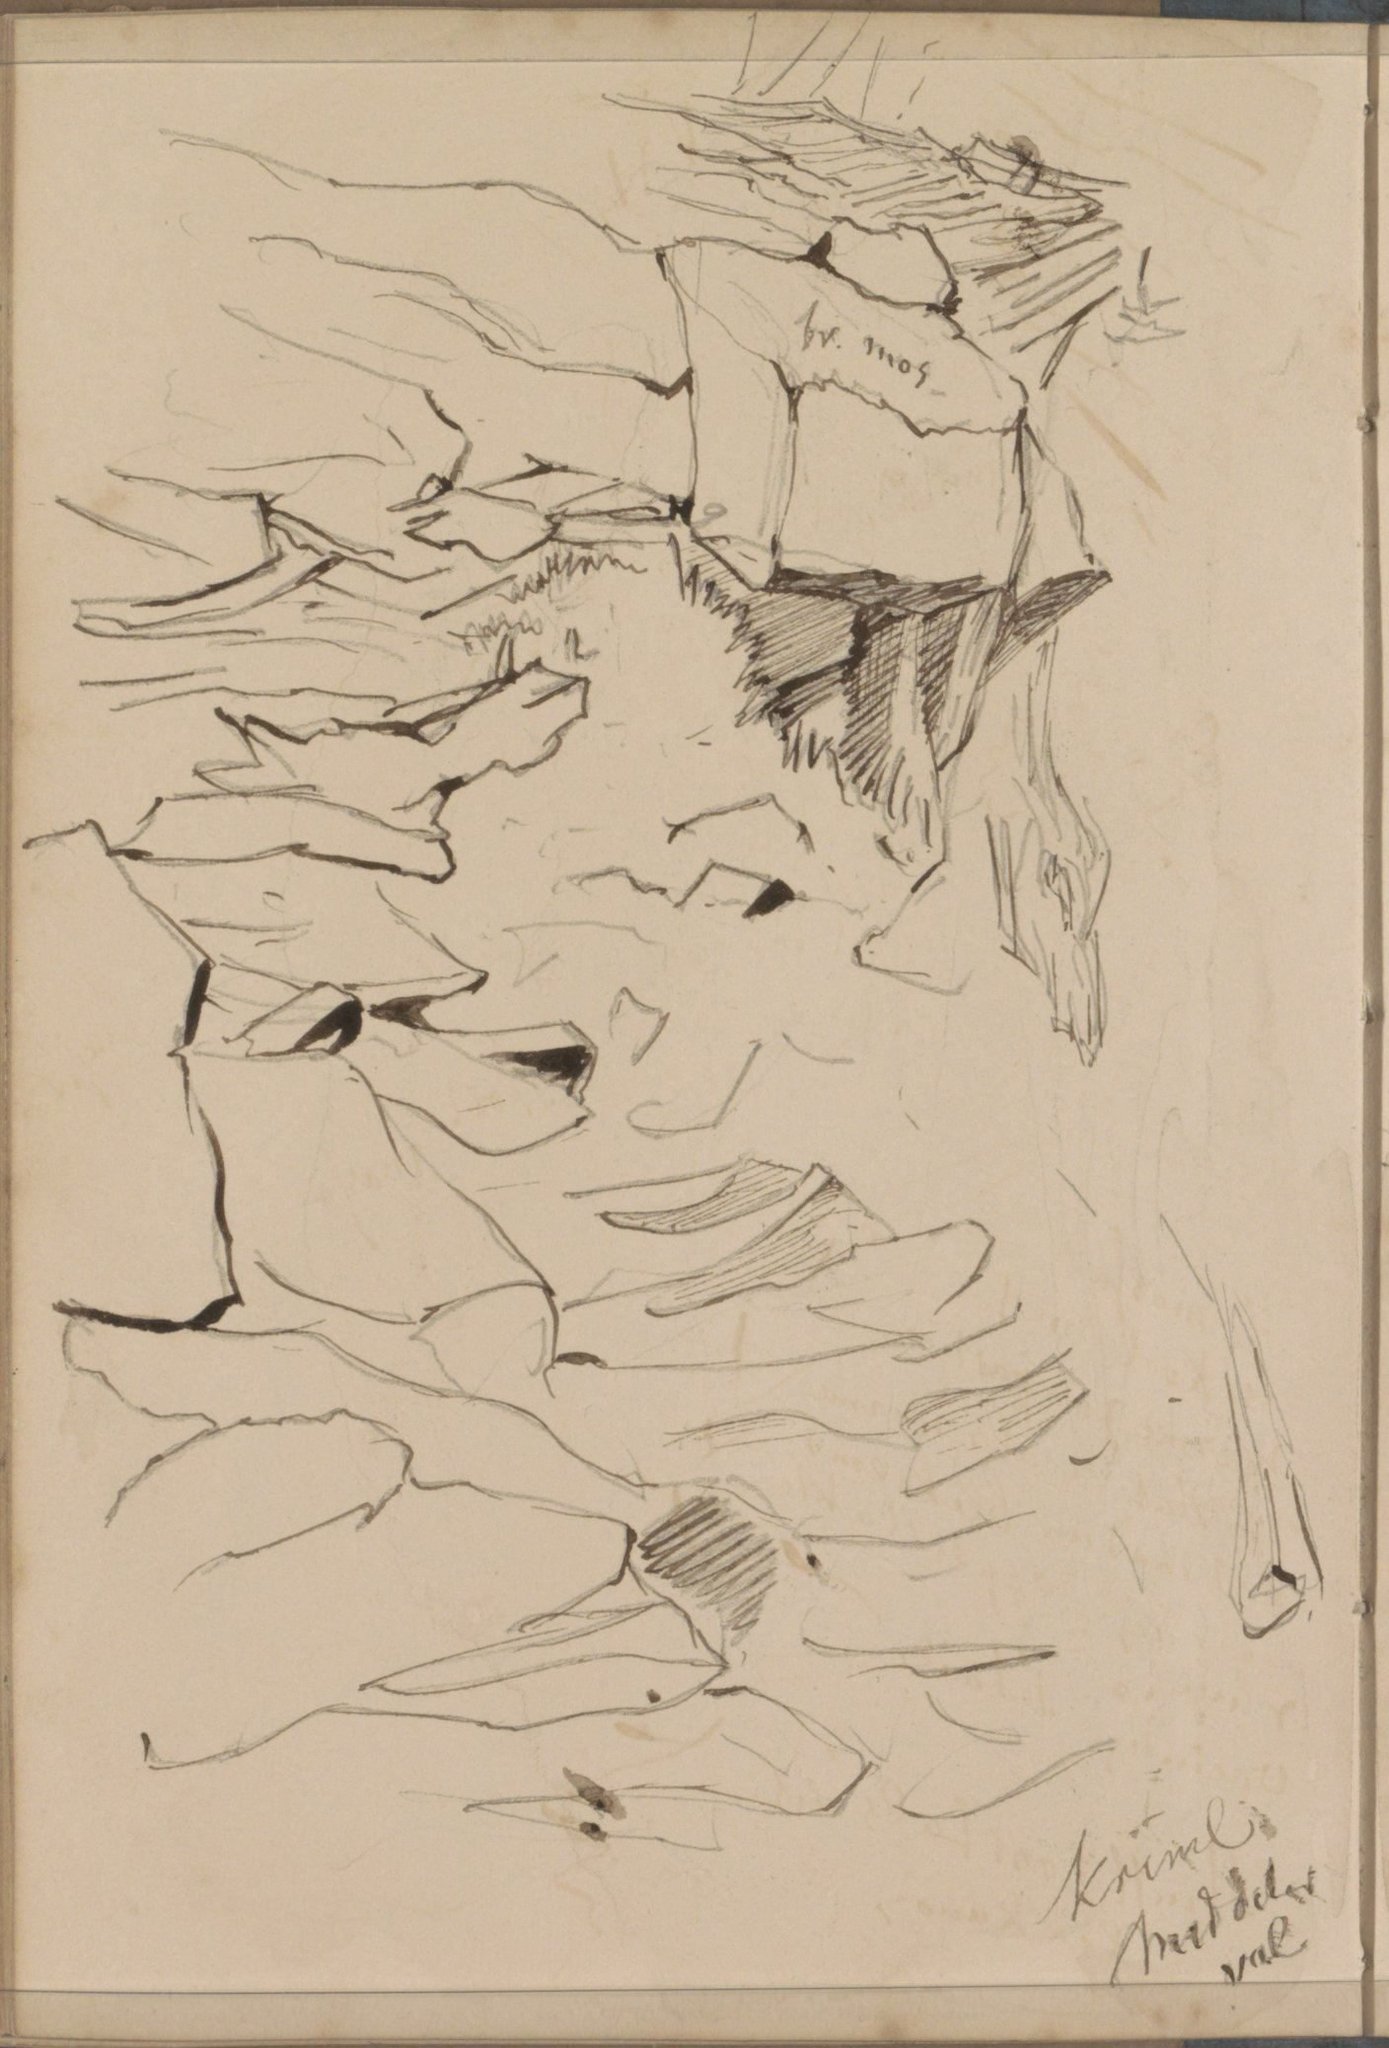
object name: sketchbook leaf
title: Waterval van Krimml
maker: johannes tavenraat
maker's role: draughtsman, painter, print maker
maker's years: 1809-1881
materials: ink, paper, pencil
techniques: pen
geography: krimml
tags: waterfall, rocks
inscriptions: annotation: ‘Kriml/ met de[..]/ val’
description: Blad 21 verso uit een schetsboek met 47 bladen.